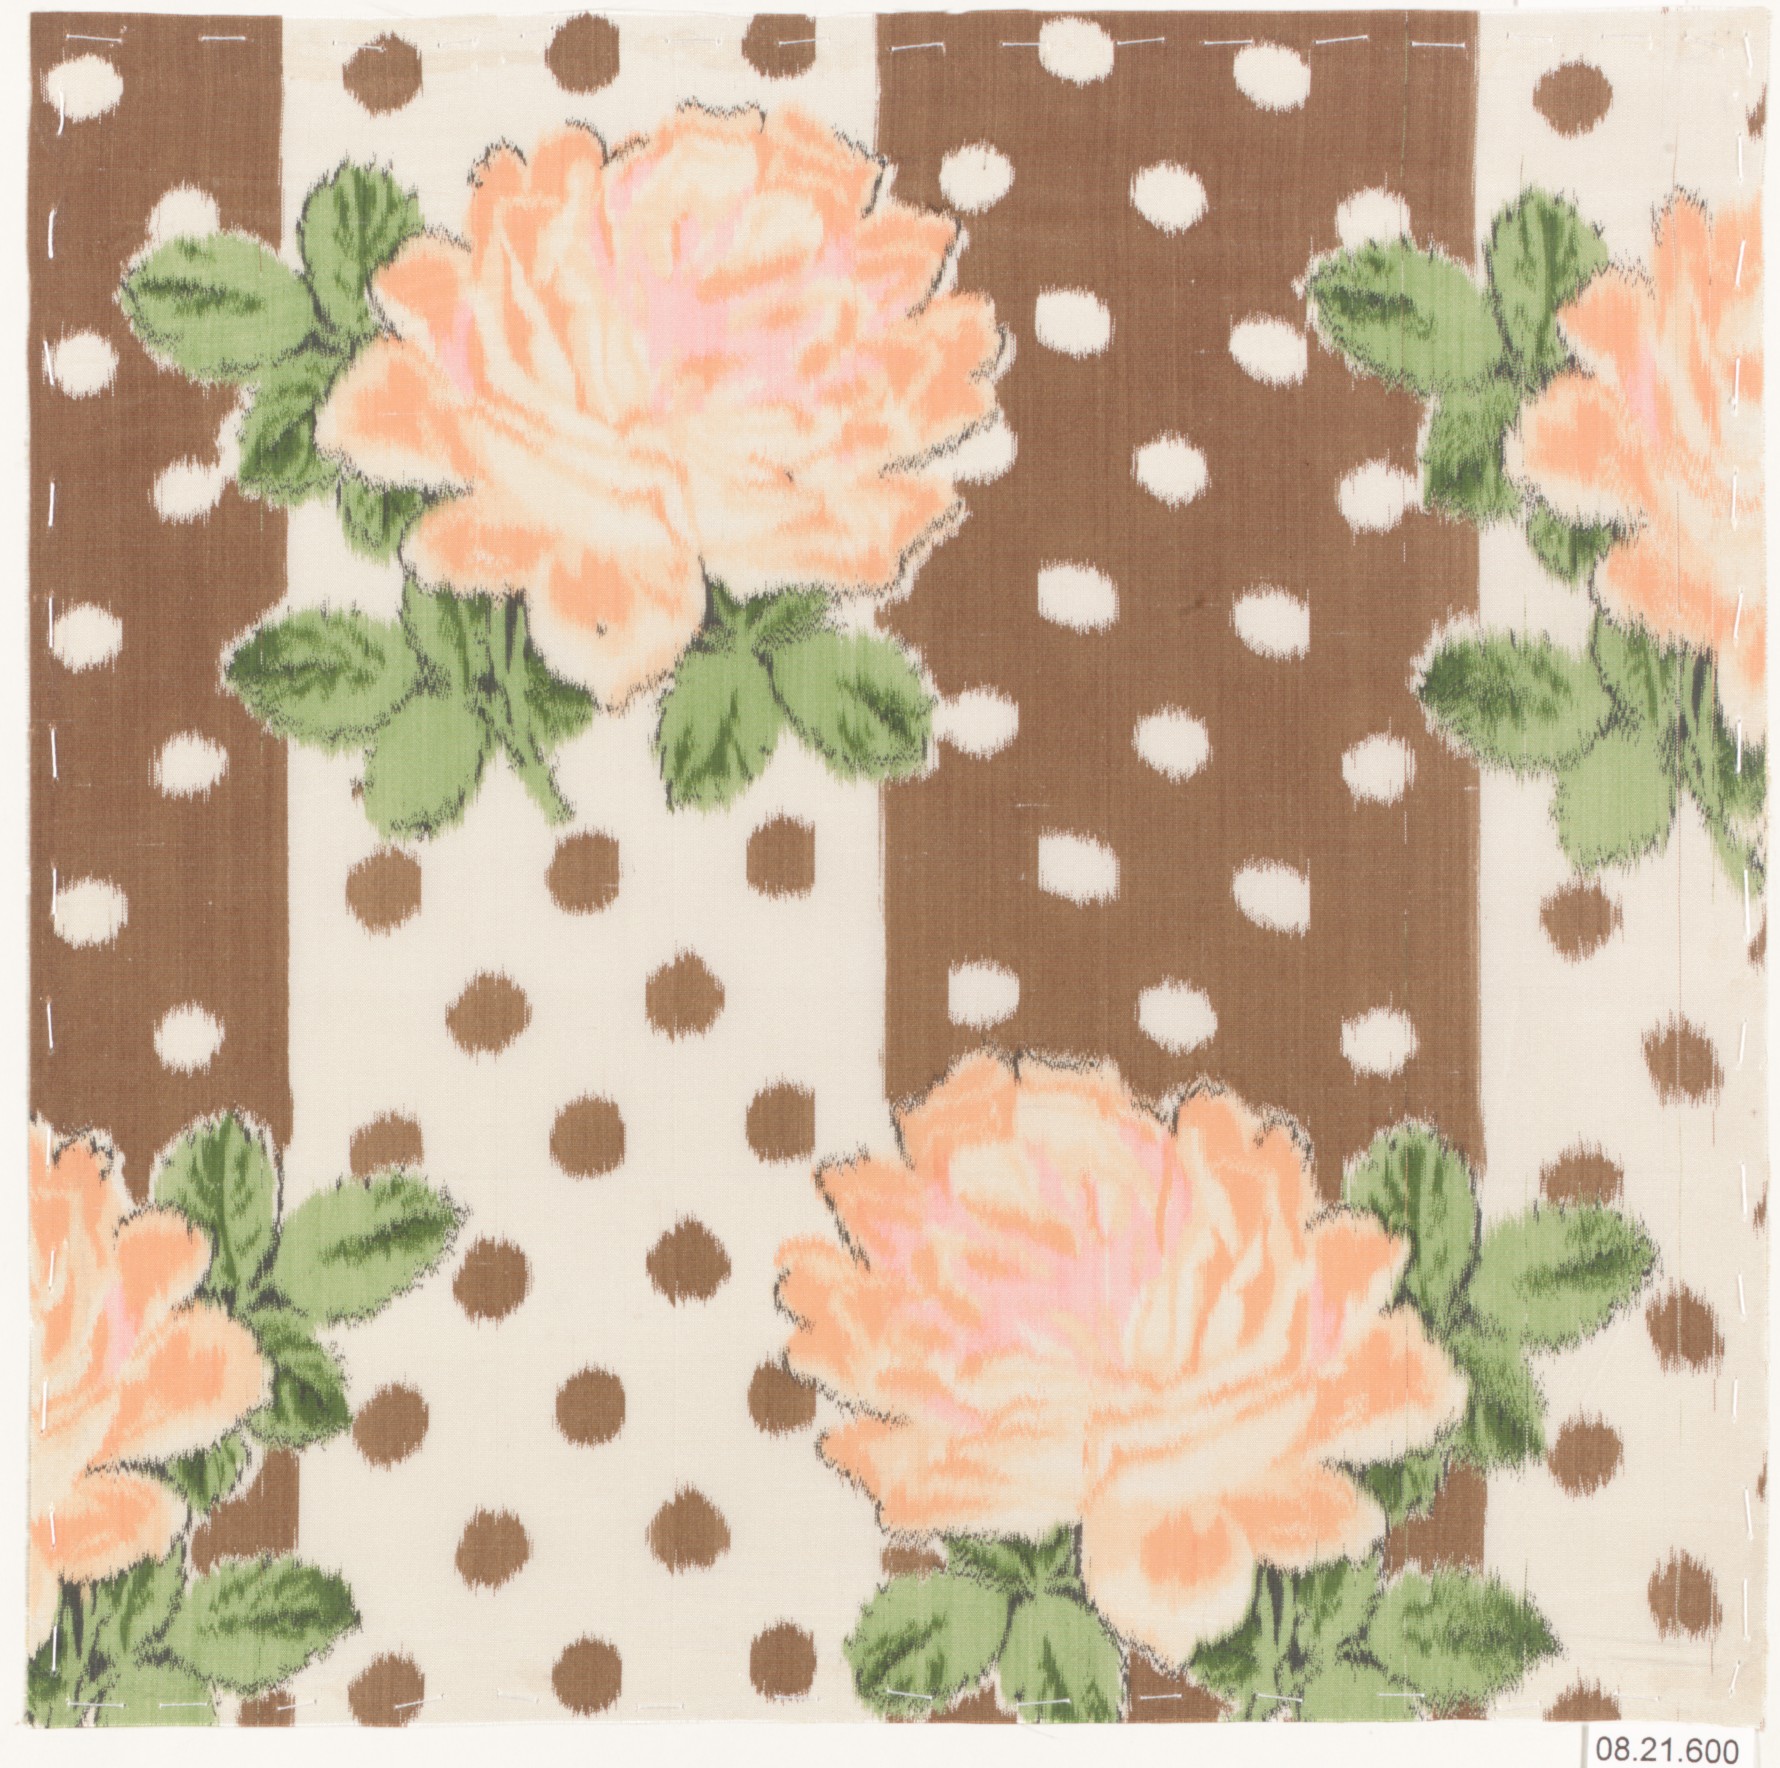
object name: textile sample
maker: Anonymous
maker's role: designer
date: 1900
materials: silk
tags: roses